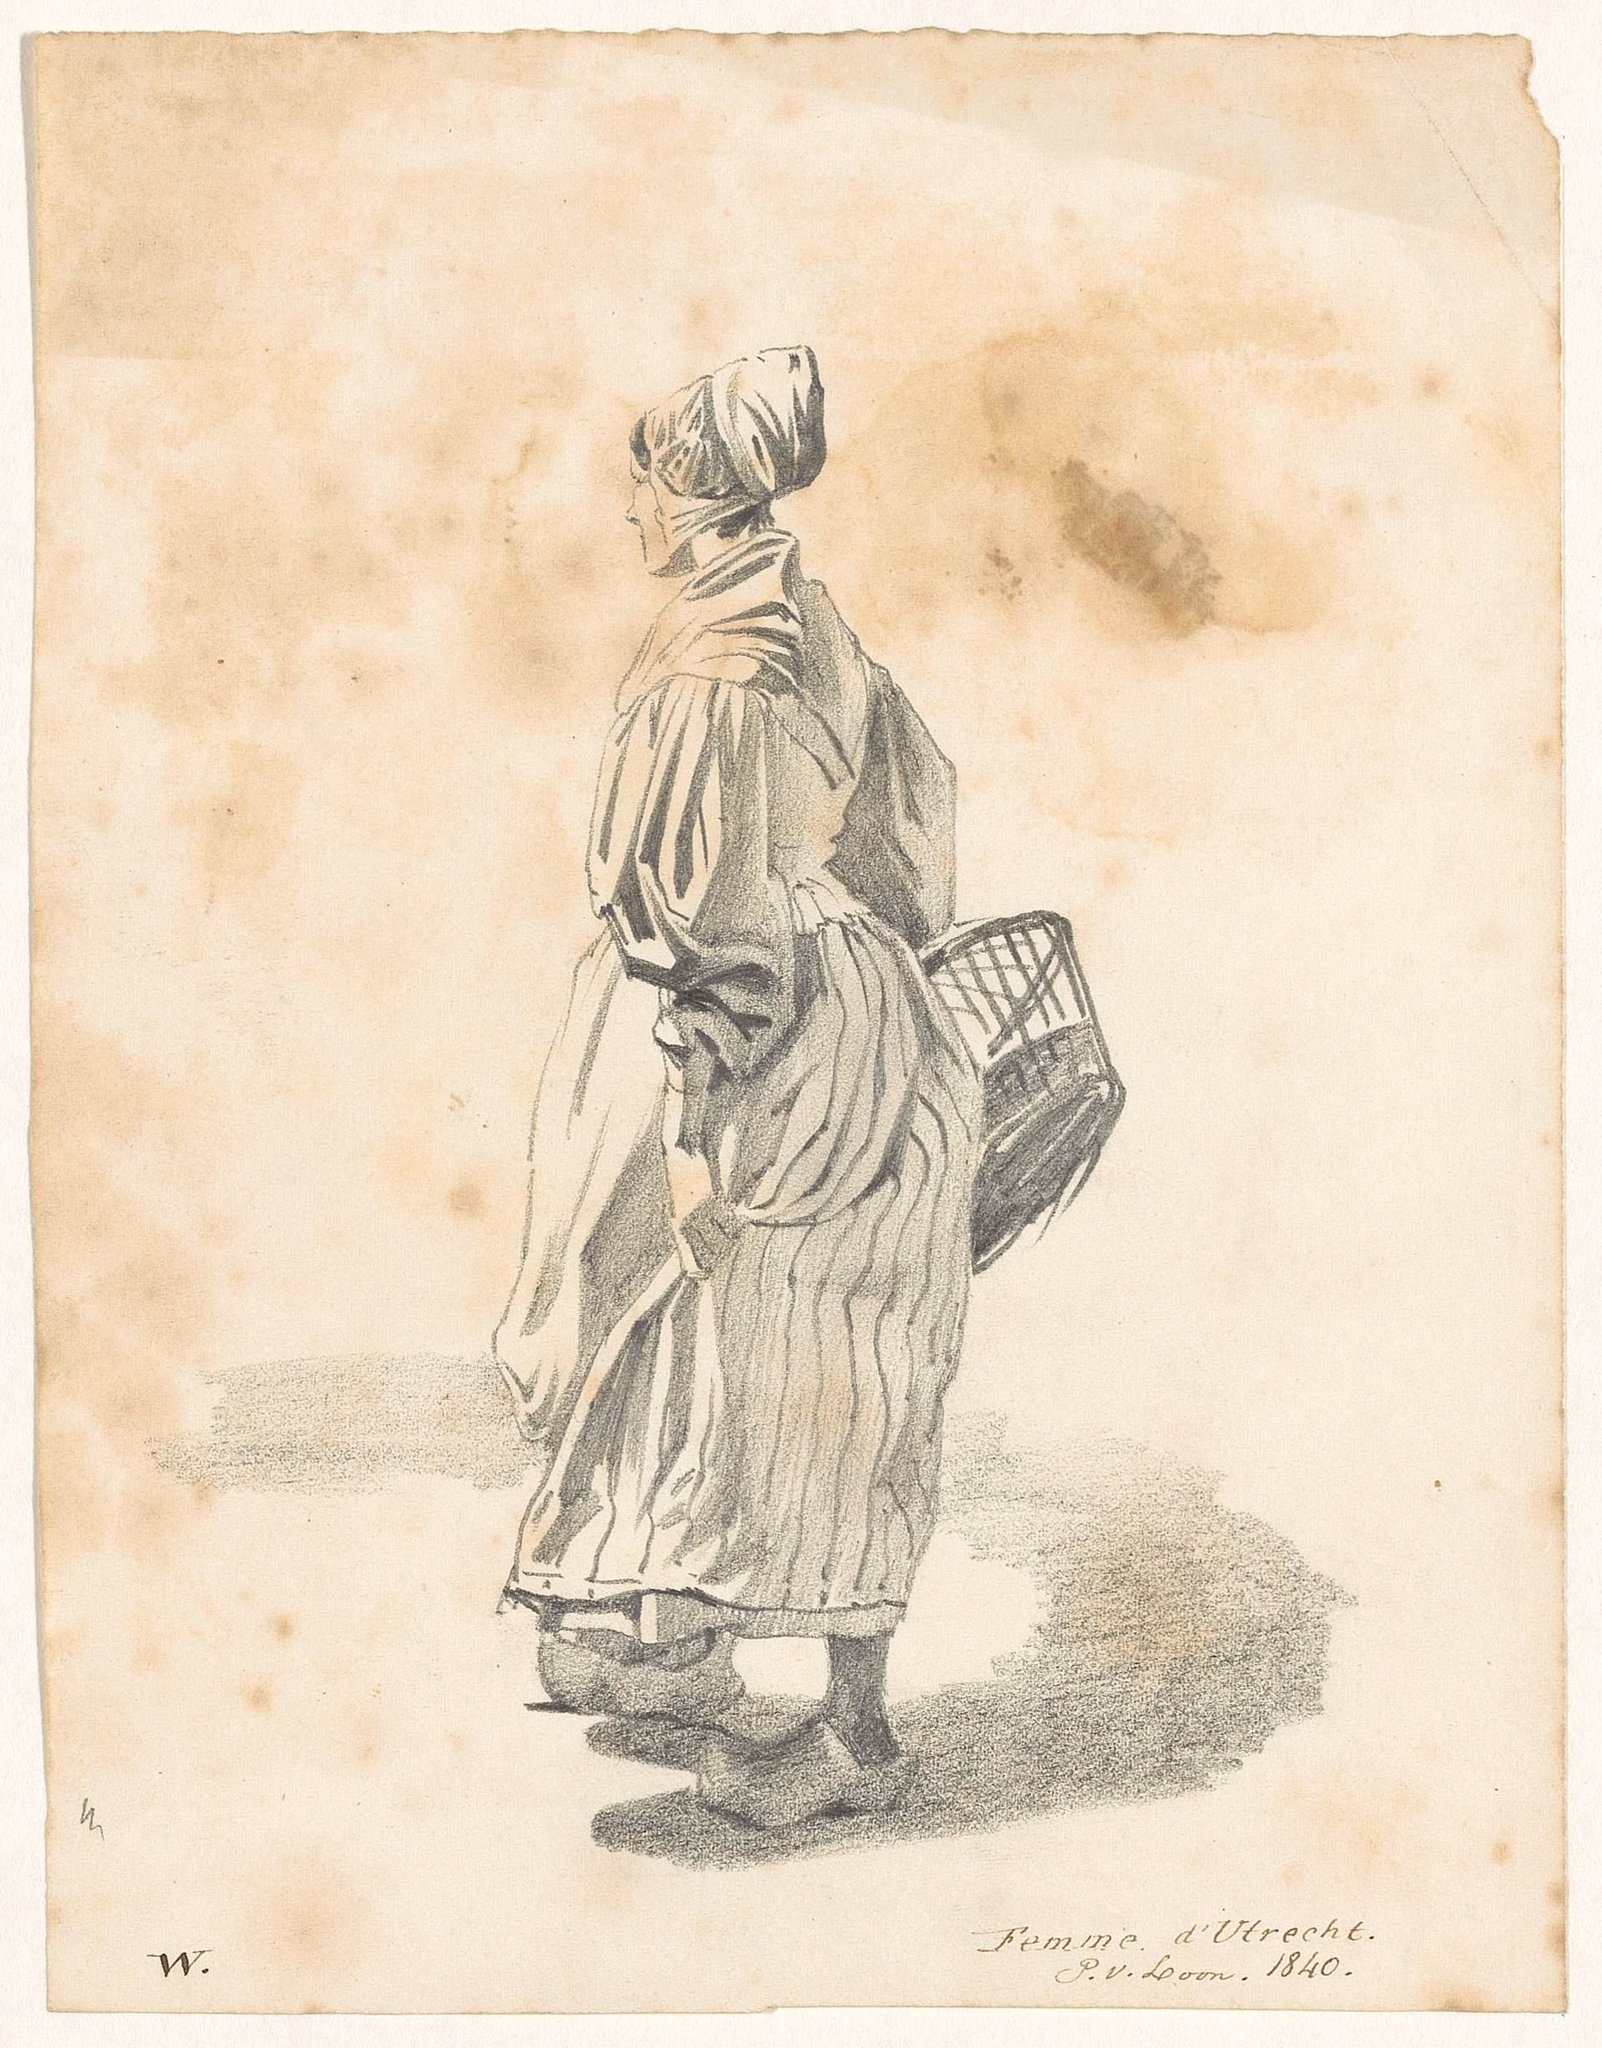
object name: drawing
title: Femme d'Utrecht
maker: pieter van loon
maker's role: draughtsman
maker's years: 1801-1873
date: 1840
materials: paper, pencil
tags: folk costume, regional costume, utrecht